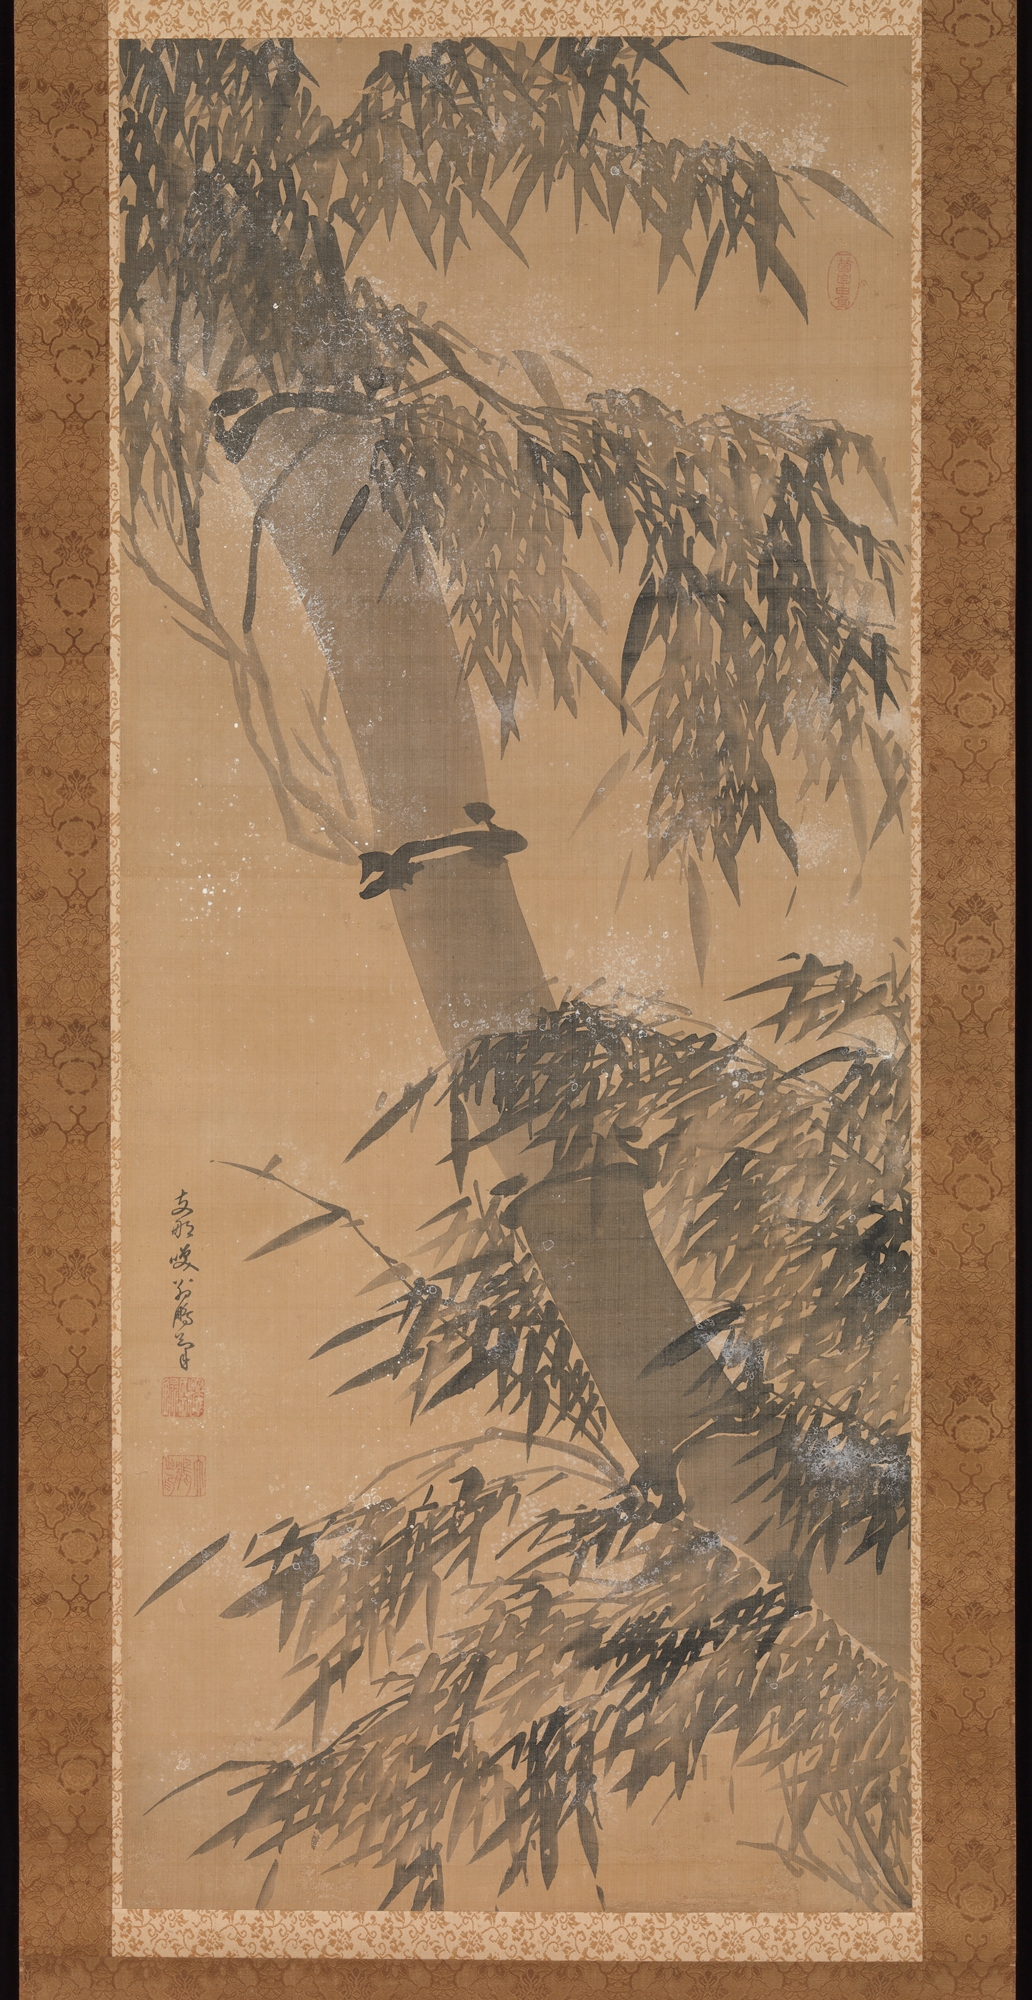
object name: hanging scroll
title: Bamboo in Snow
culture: japanese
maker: taihō shōkon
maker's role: artist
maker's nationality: chinese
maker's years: 1691-1774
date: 1774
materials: ink, silk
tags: bamboo